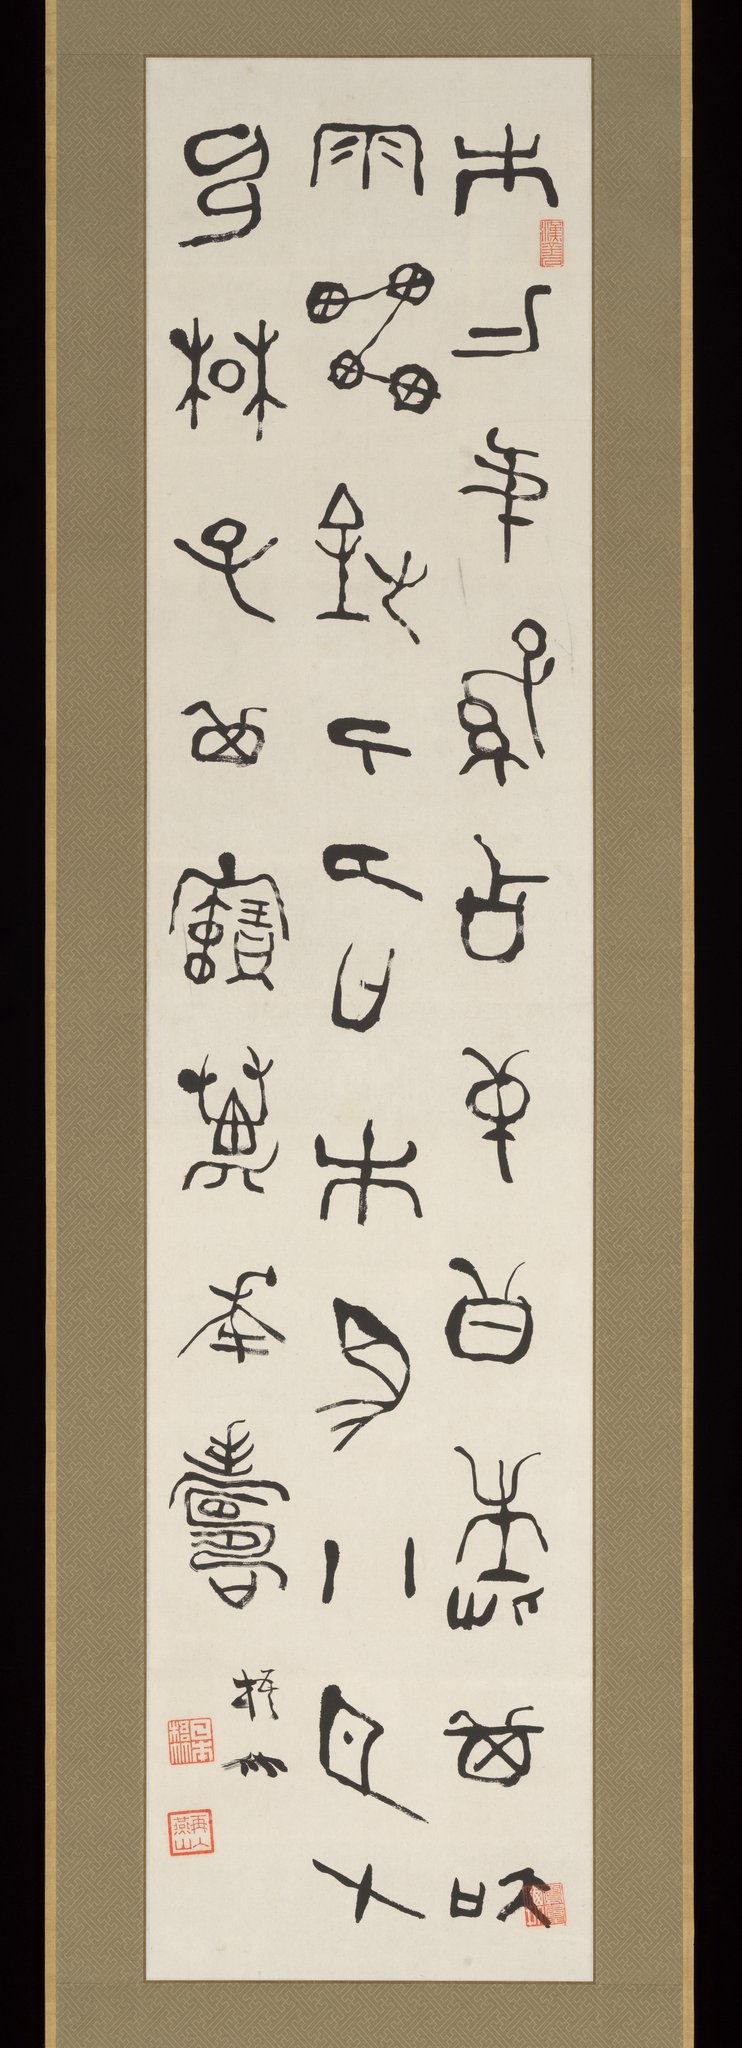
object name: hanging scroll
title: Copy of the Inscription on the Chugong Bell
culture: japanese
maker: nakabayashi gochiku i 中林梧竹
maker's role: artist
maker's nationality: japanese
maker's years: 1827-1913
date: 1901-1933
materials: ink, paper